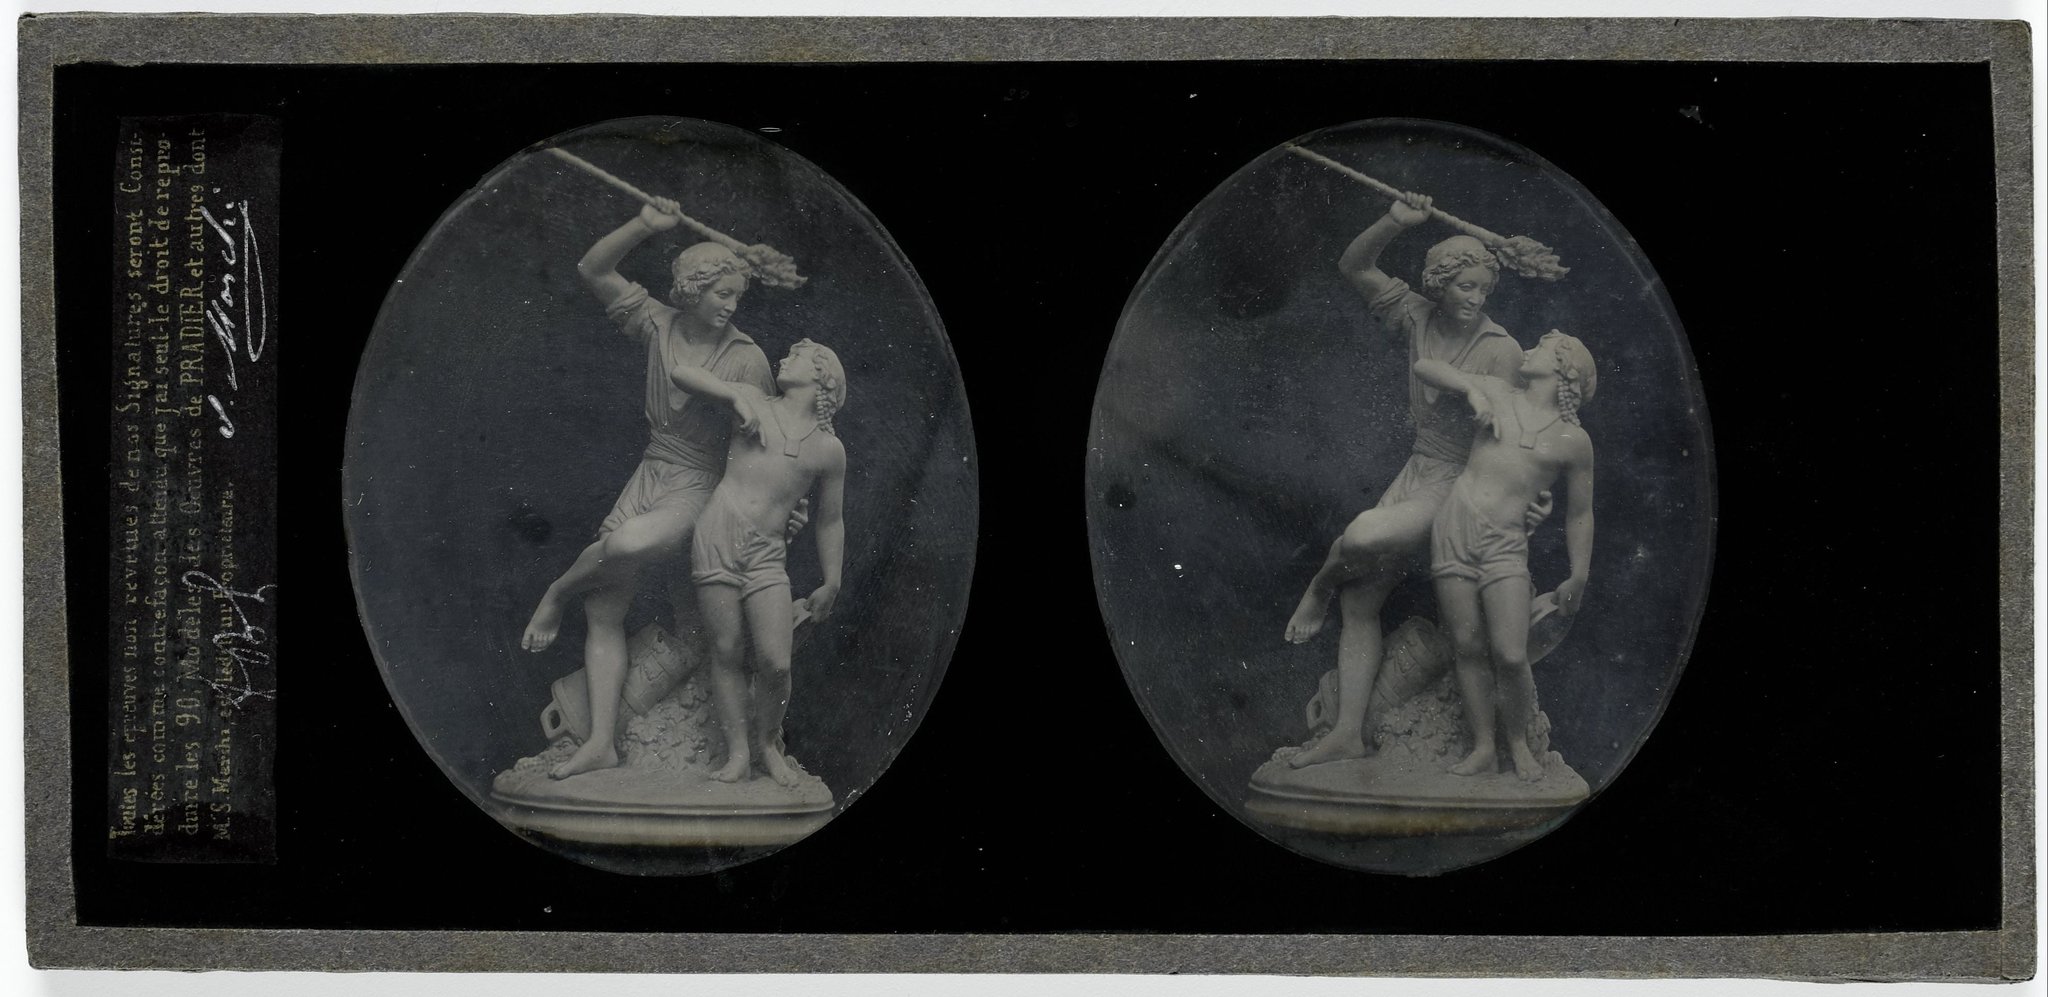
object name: stereograph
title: Sculptuur door Jean-Jaques Pradier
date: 1853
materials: copper, glass, paper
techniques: daguerreotype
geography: france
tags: sculpture, france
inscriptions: inscription: ‘Toutes les épreuves non revêtues de nos Signatures seront Consi-/ dérées comme contrefacon, attendu que j'ai seul-le droit de repro-/ duire tous les 90; Modéles des Oeuvres de PRADIERet autres dont/ M. S. Marchi, est l'éditeur Propriétaire.’